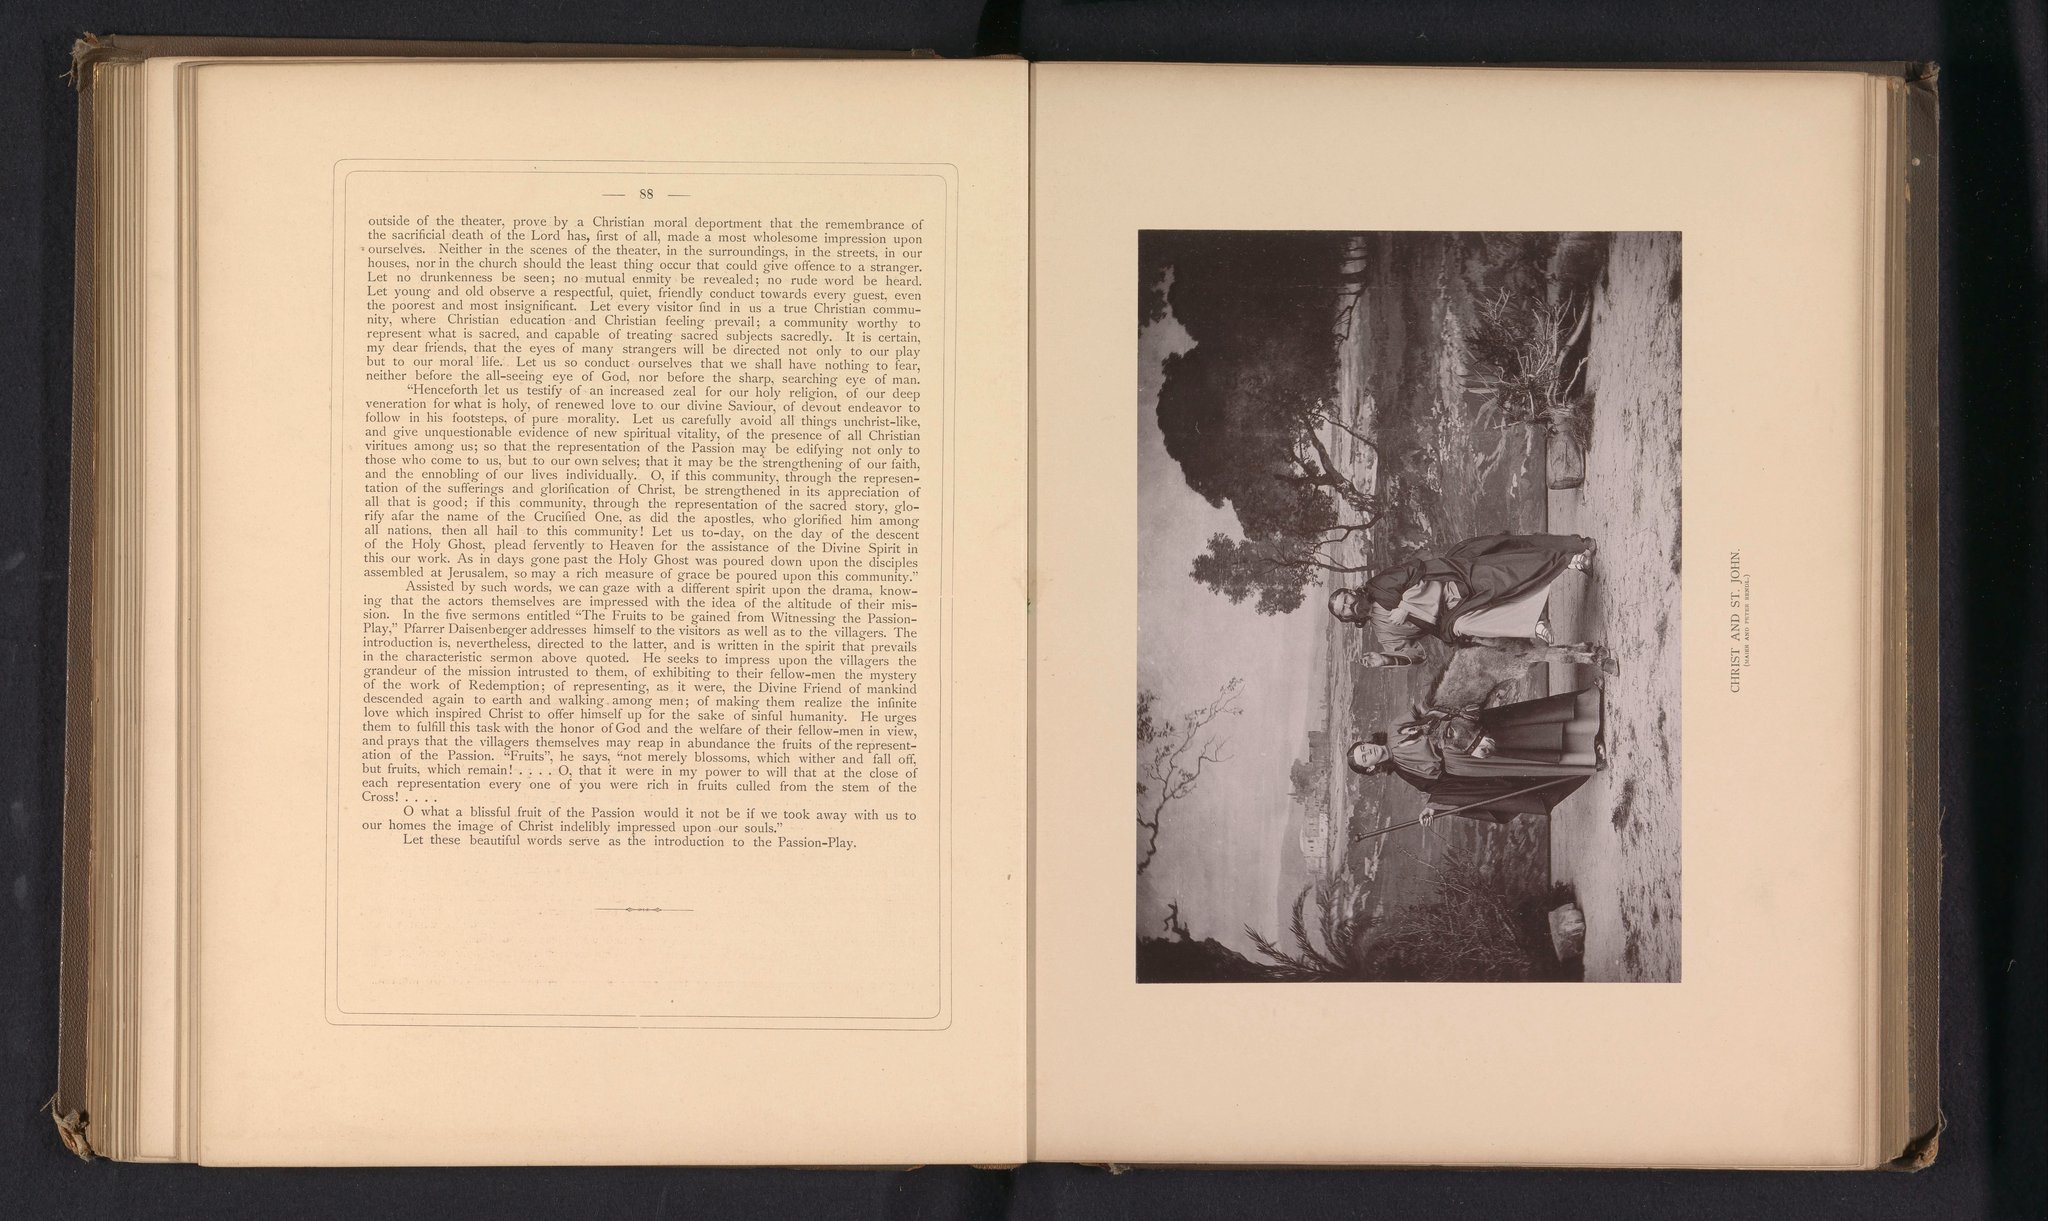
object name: photomechanical print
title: Christ and St. John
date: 1885-1890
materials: paper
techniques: photograph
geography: oberammergau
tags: christ, portrait of actor, actress, life and acts of john the evangelist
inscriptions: inscription: ‘Gemeinde Oberammergau Passionsspiel 1890’